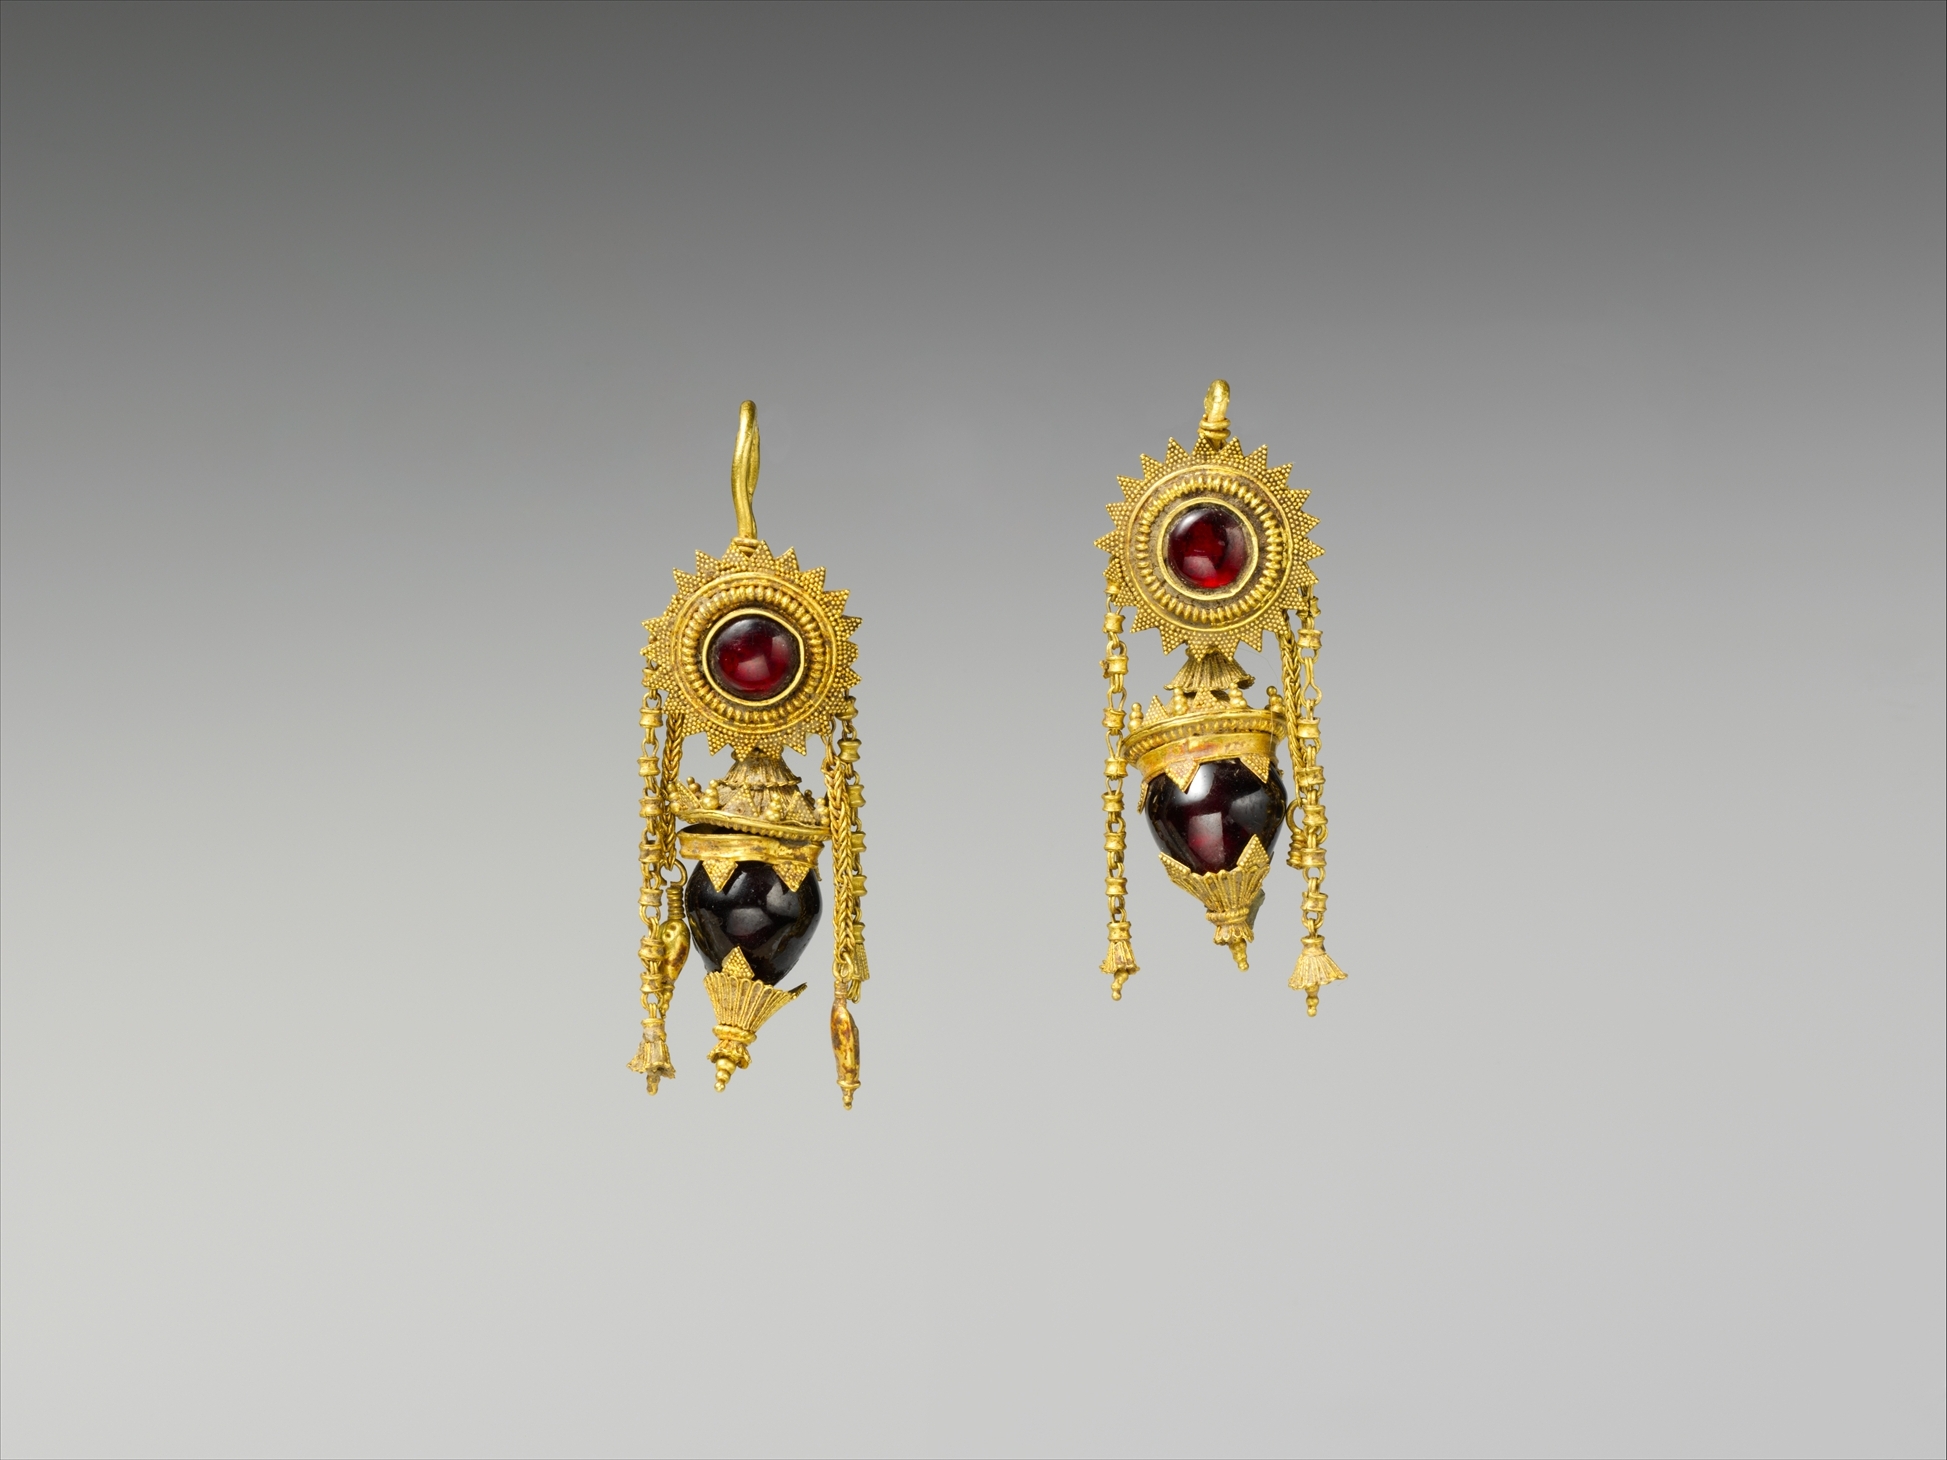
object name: earring with disc, chain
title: Earring with disc, chains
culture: etruscan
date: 900-100 BCE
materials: gold